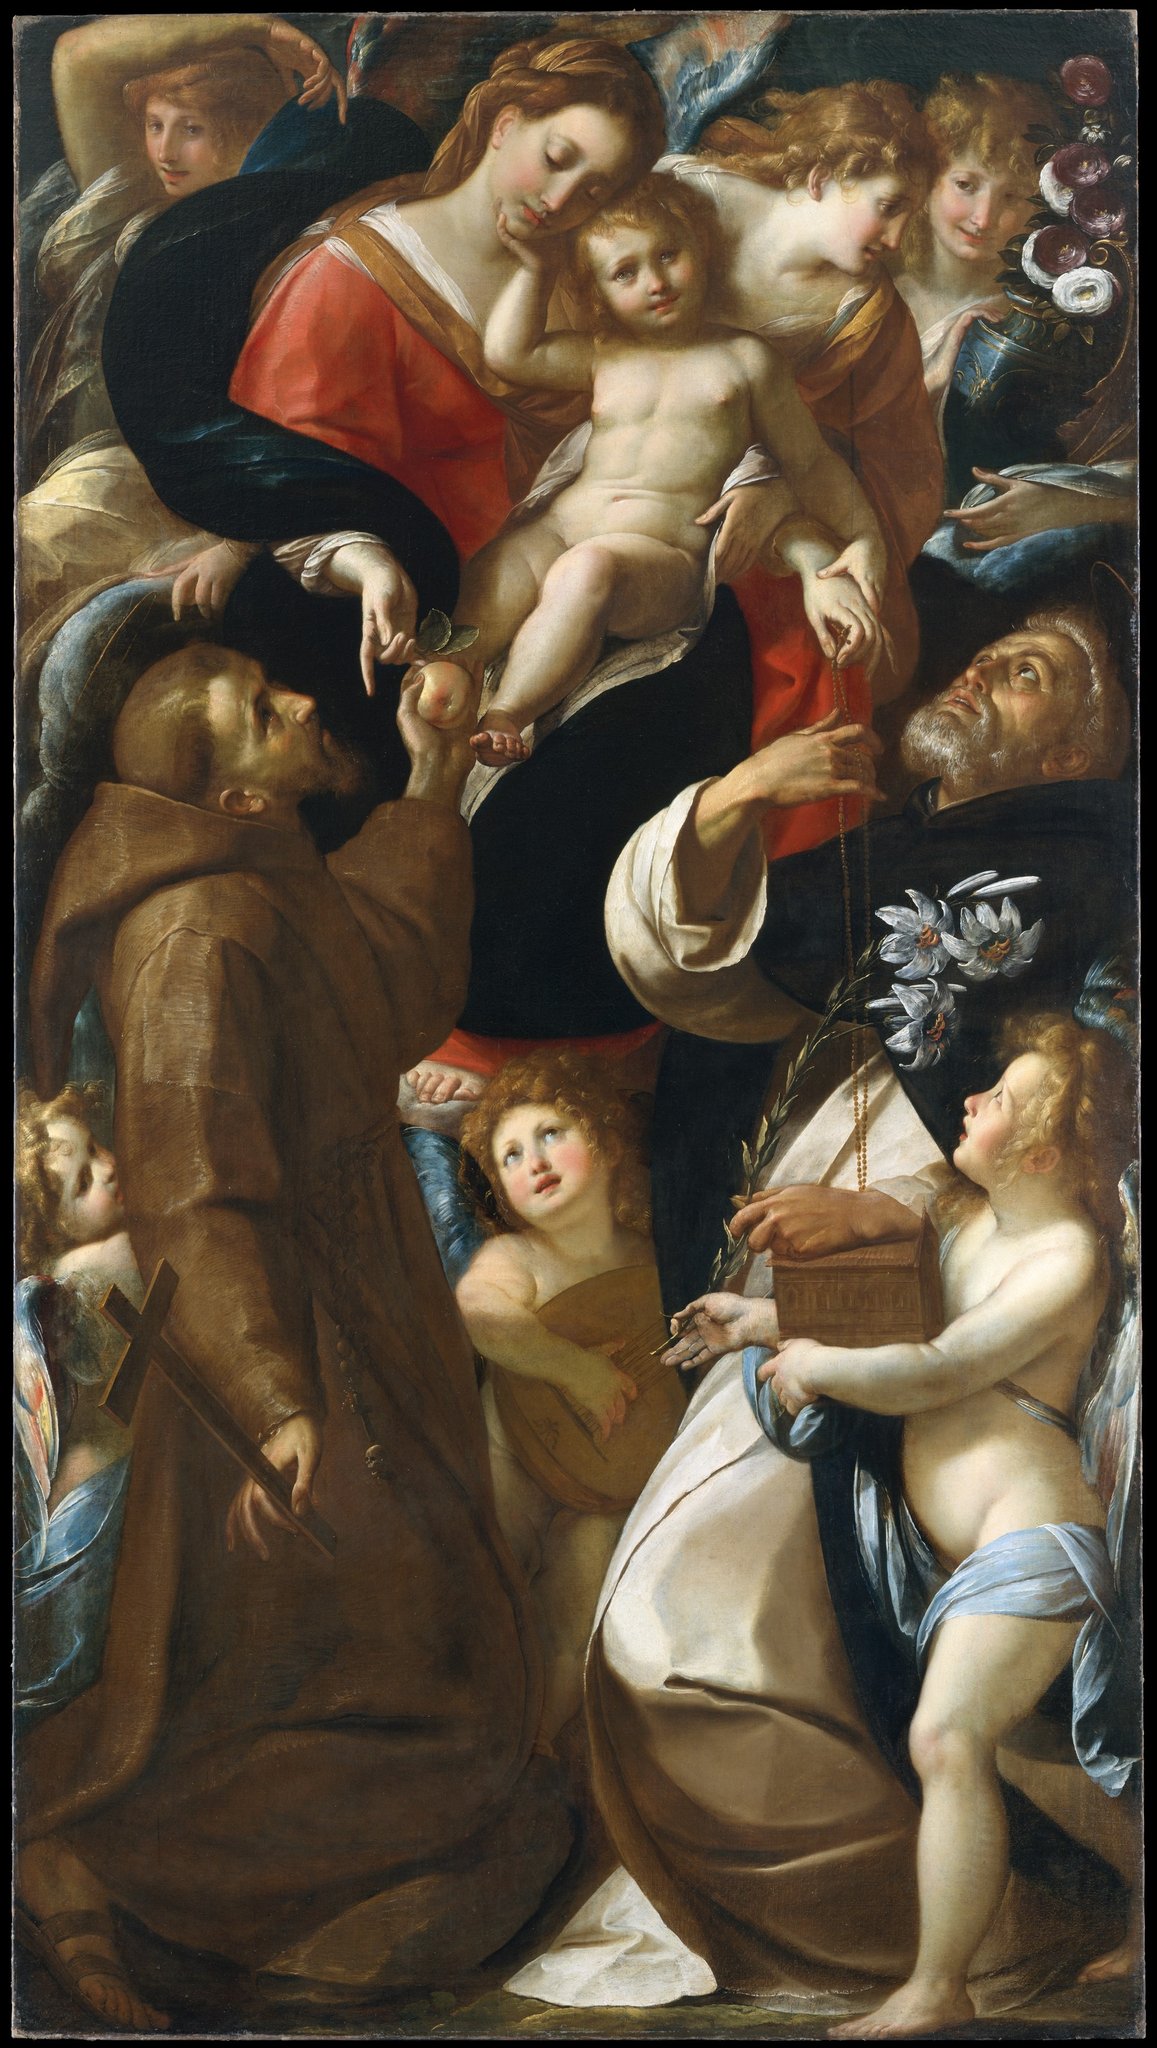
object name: painting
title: Madonna and Child with Saints Francis and Dominic and Angels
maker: giulio cesare procaccini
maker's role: artist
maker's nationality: italian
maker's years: 1574-1625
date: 1612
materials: canvas, oil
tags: angels,madonna and child,saints